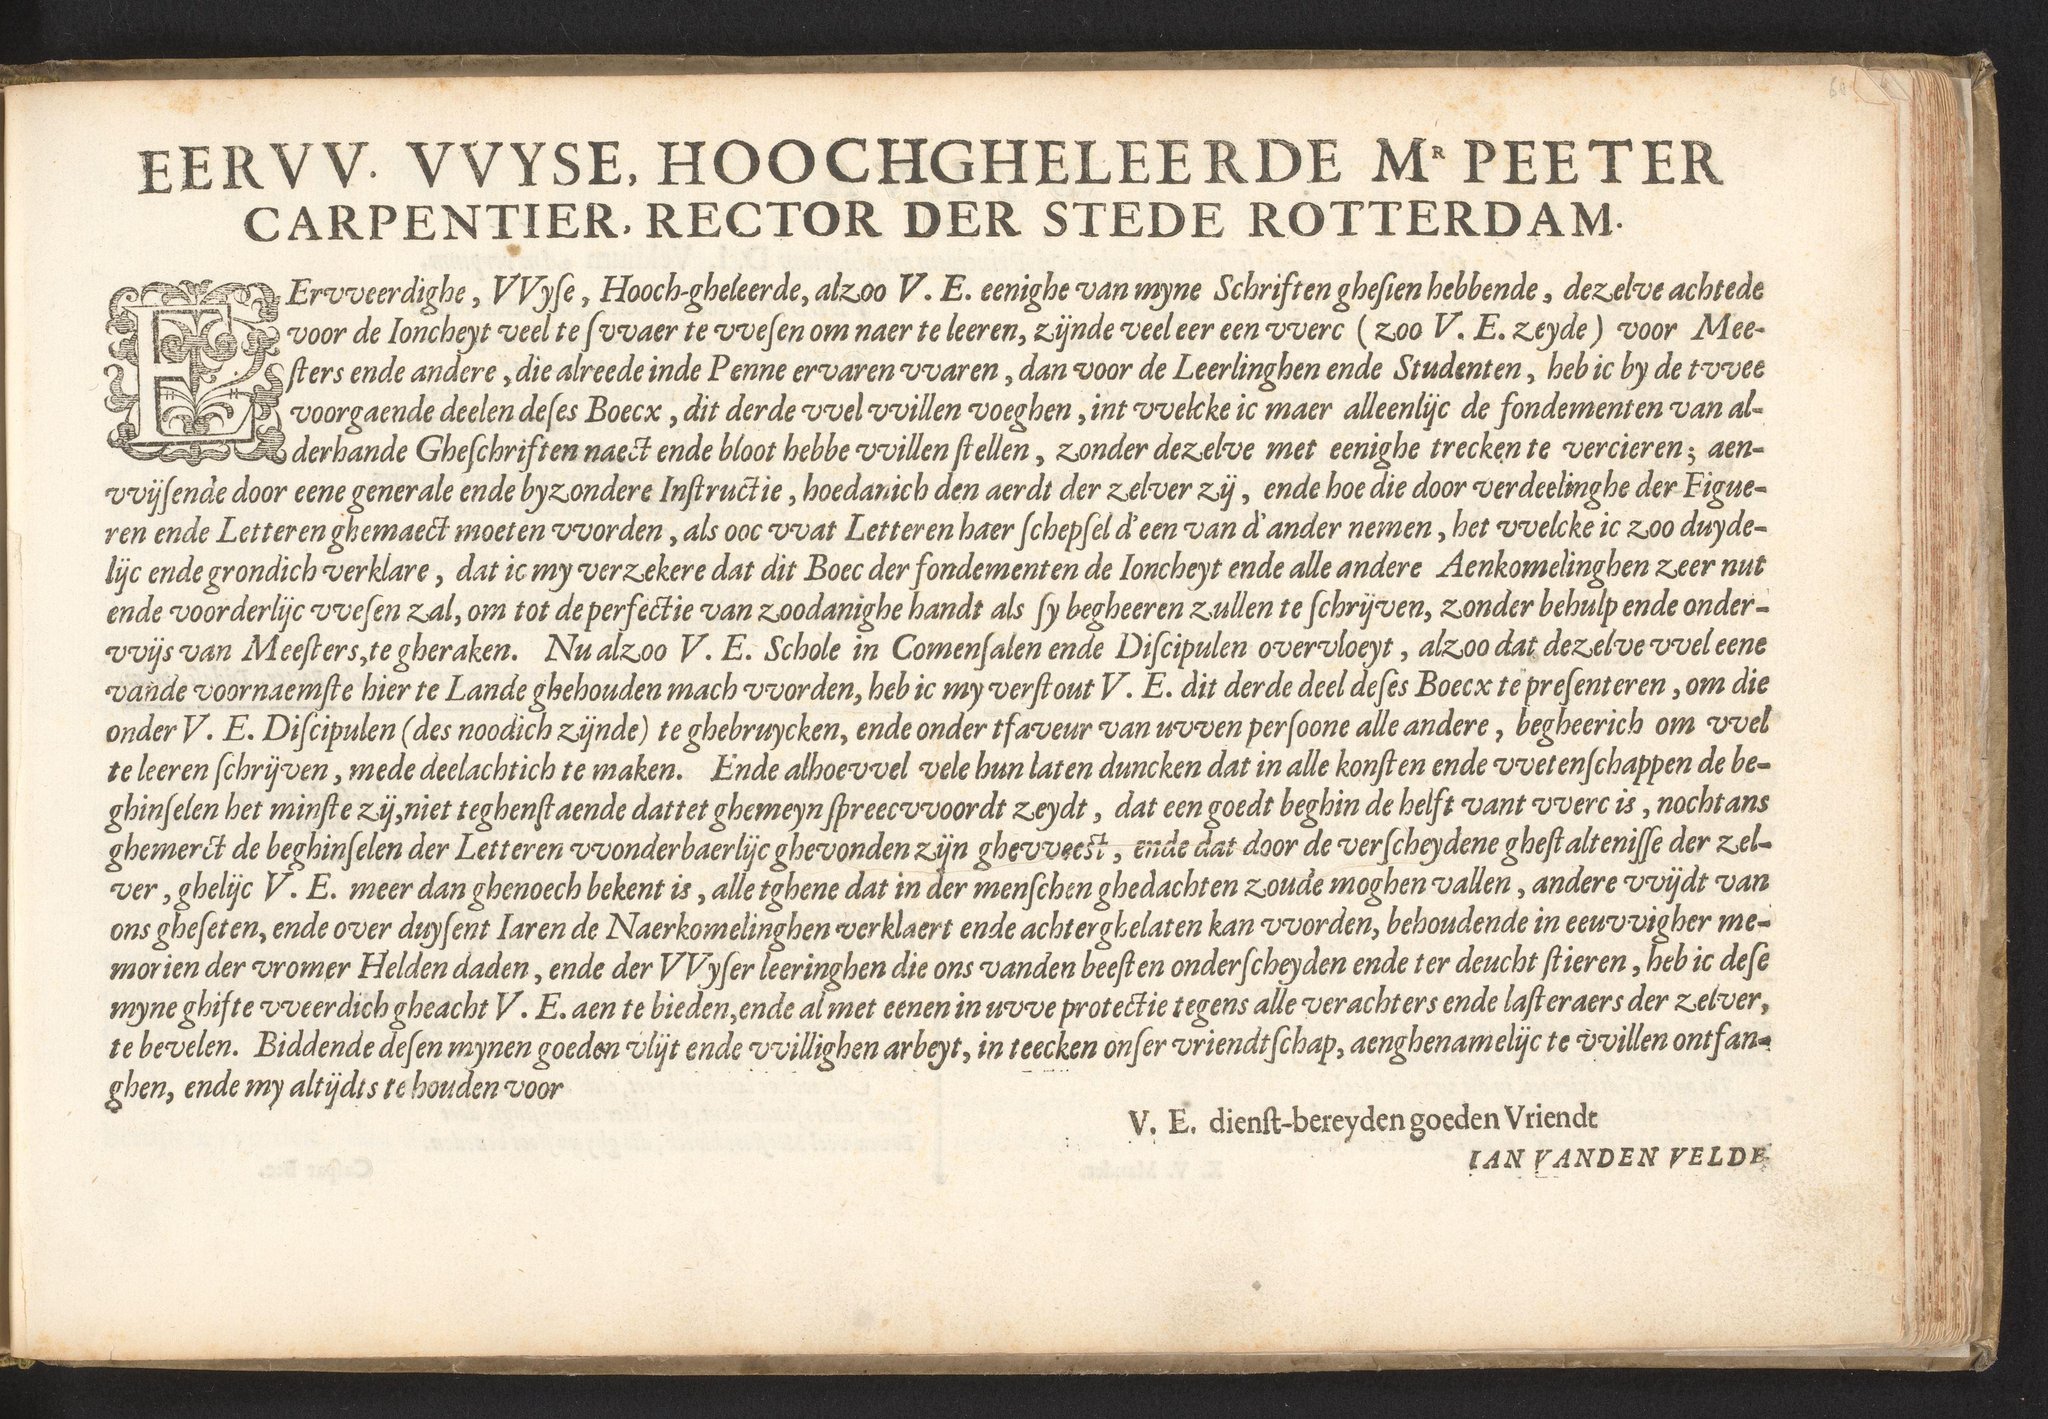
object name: text sheet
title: Spieghel der schrijfkonste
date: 1605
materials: paper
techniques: letterpress printing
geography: rotterdam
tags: initial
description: Tekstblad met dedicatie aan Pieter de Carpentier. De tekst begint met een gedecoreerde initiaal E. Het tekstblad maakt deel uit van een album.